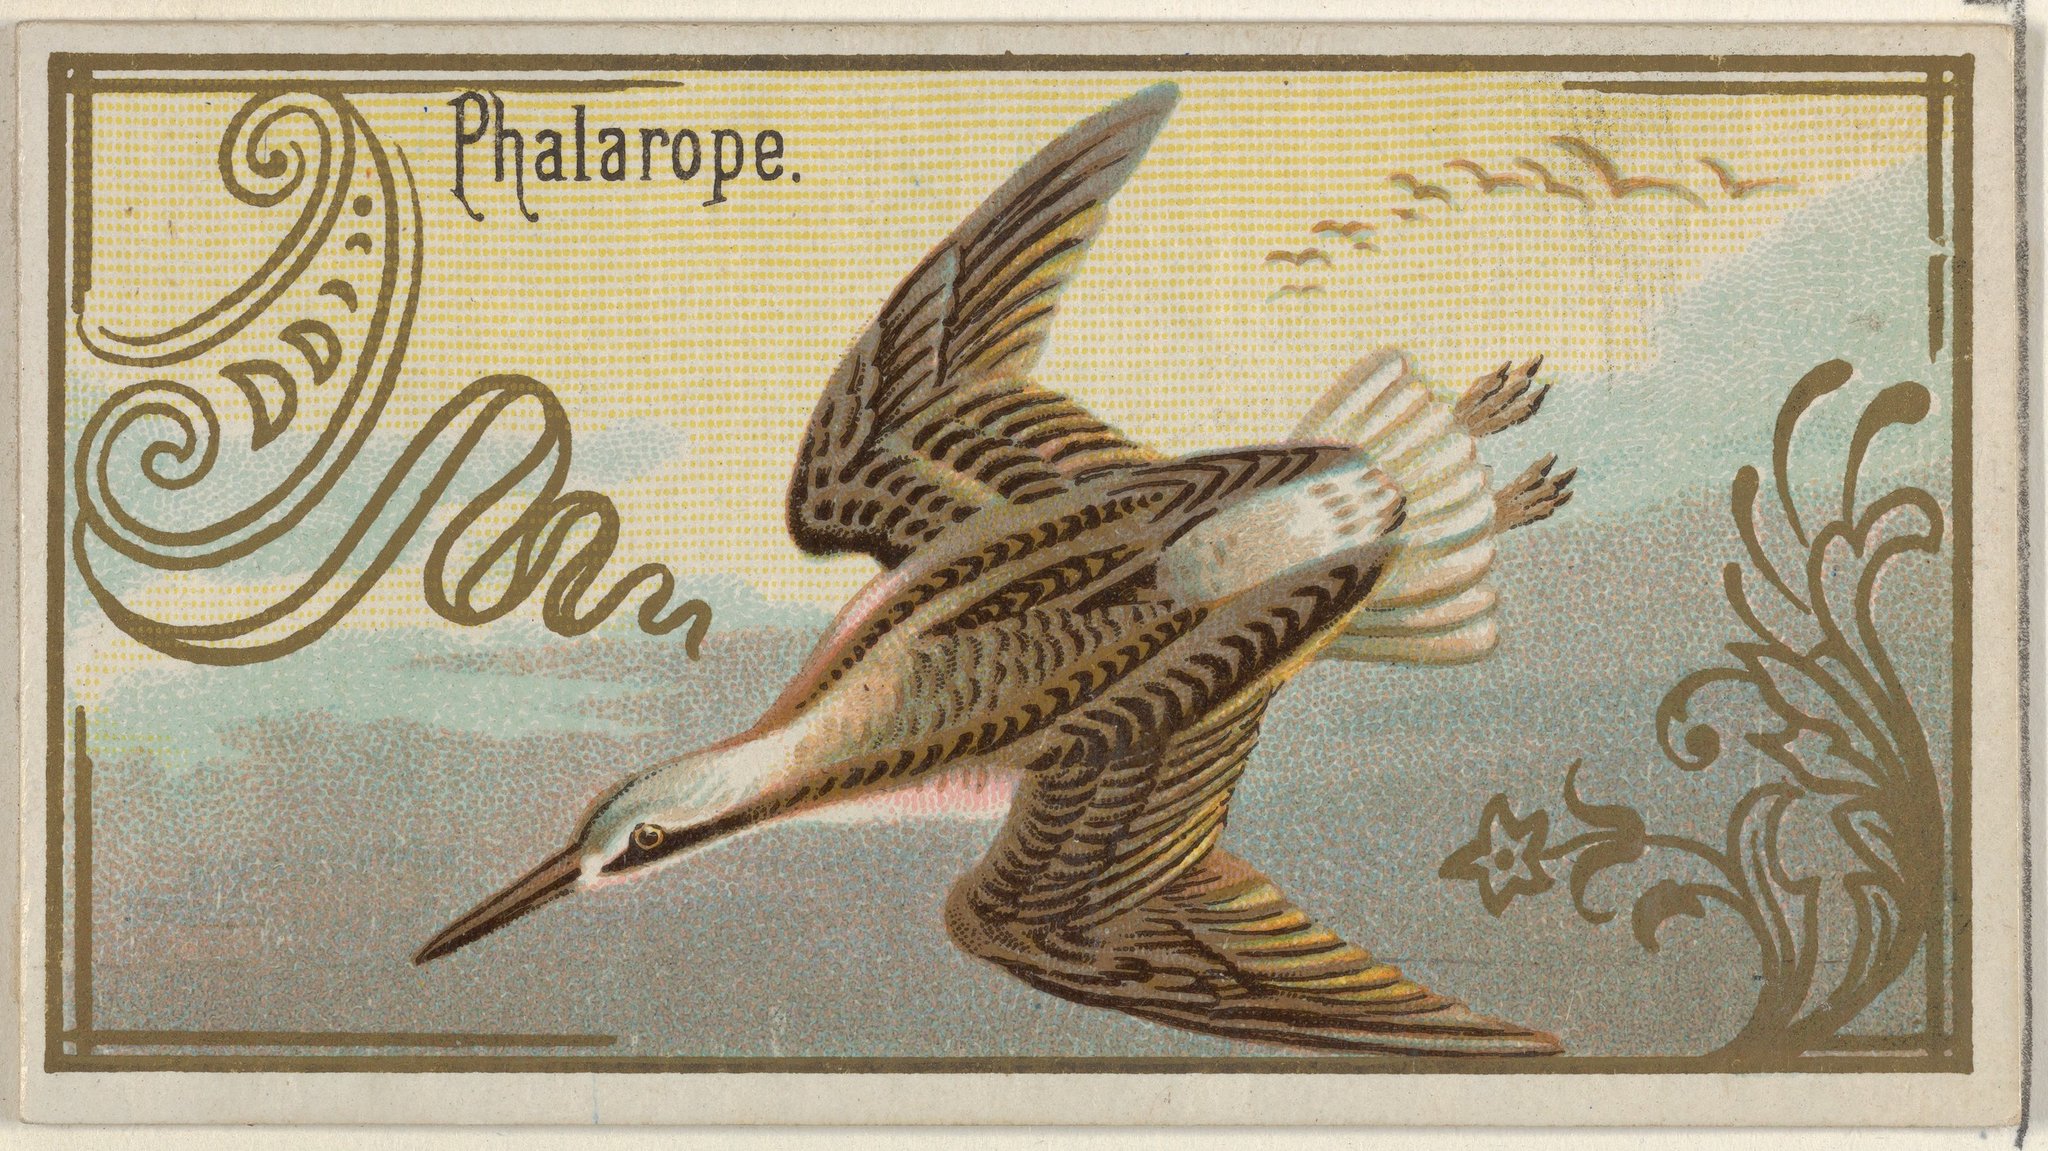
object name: print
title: Phalarope, from the Game Birds series (N13) for Allen & Ginter Cigarettes Brands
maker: allen & ginter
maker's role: publisher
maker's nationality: american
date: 1889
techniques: color lithograph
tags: birds